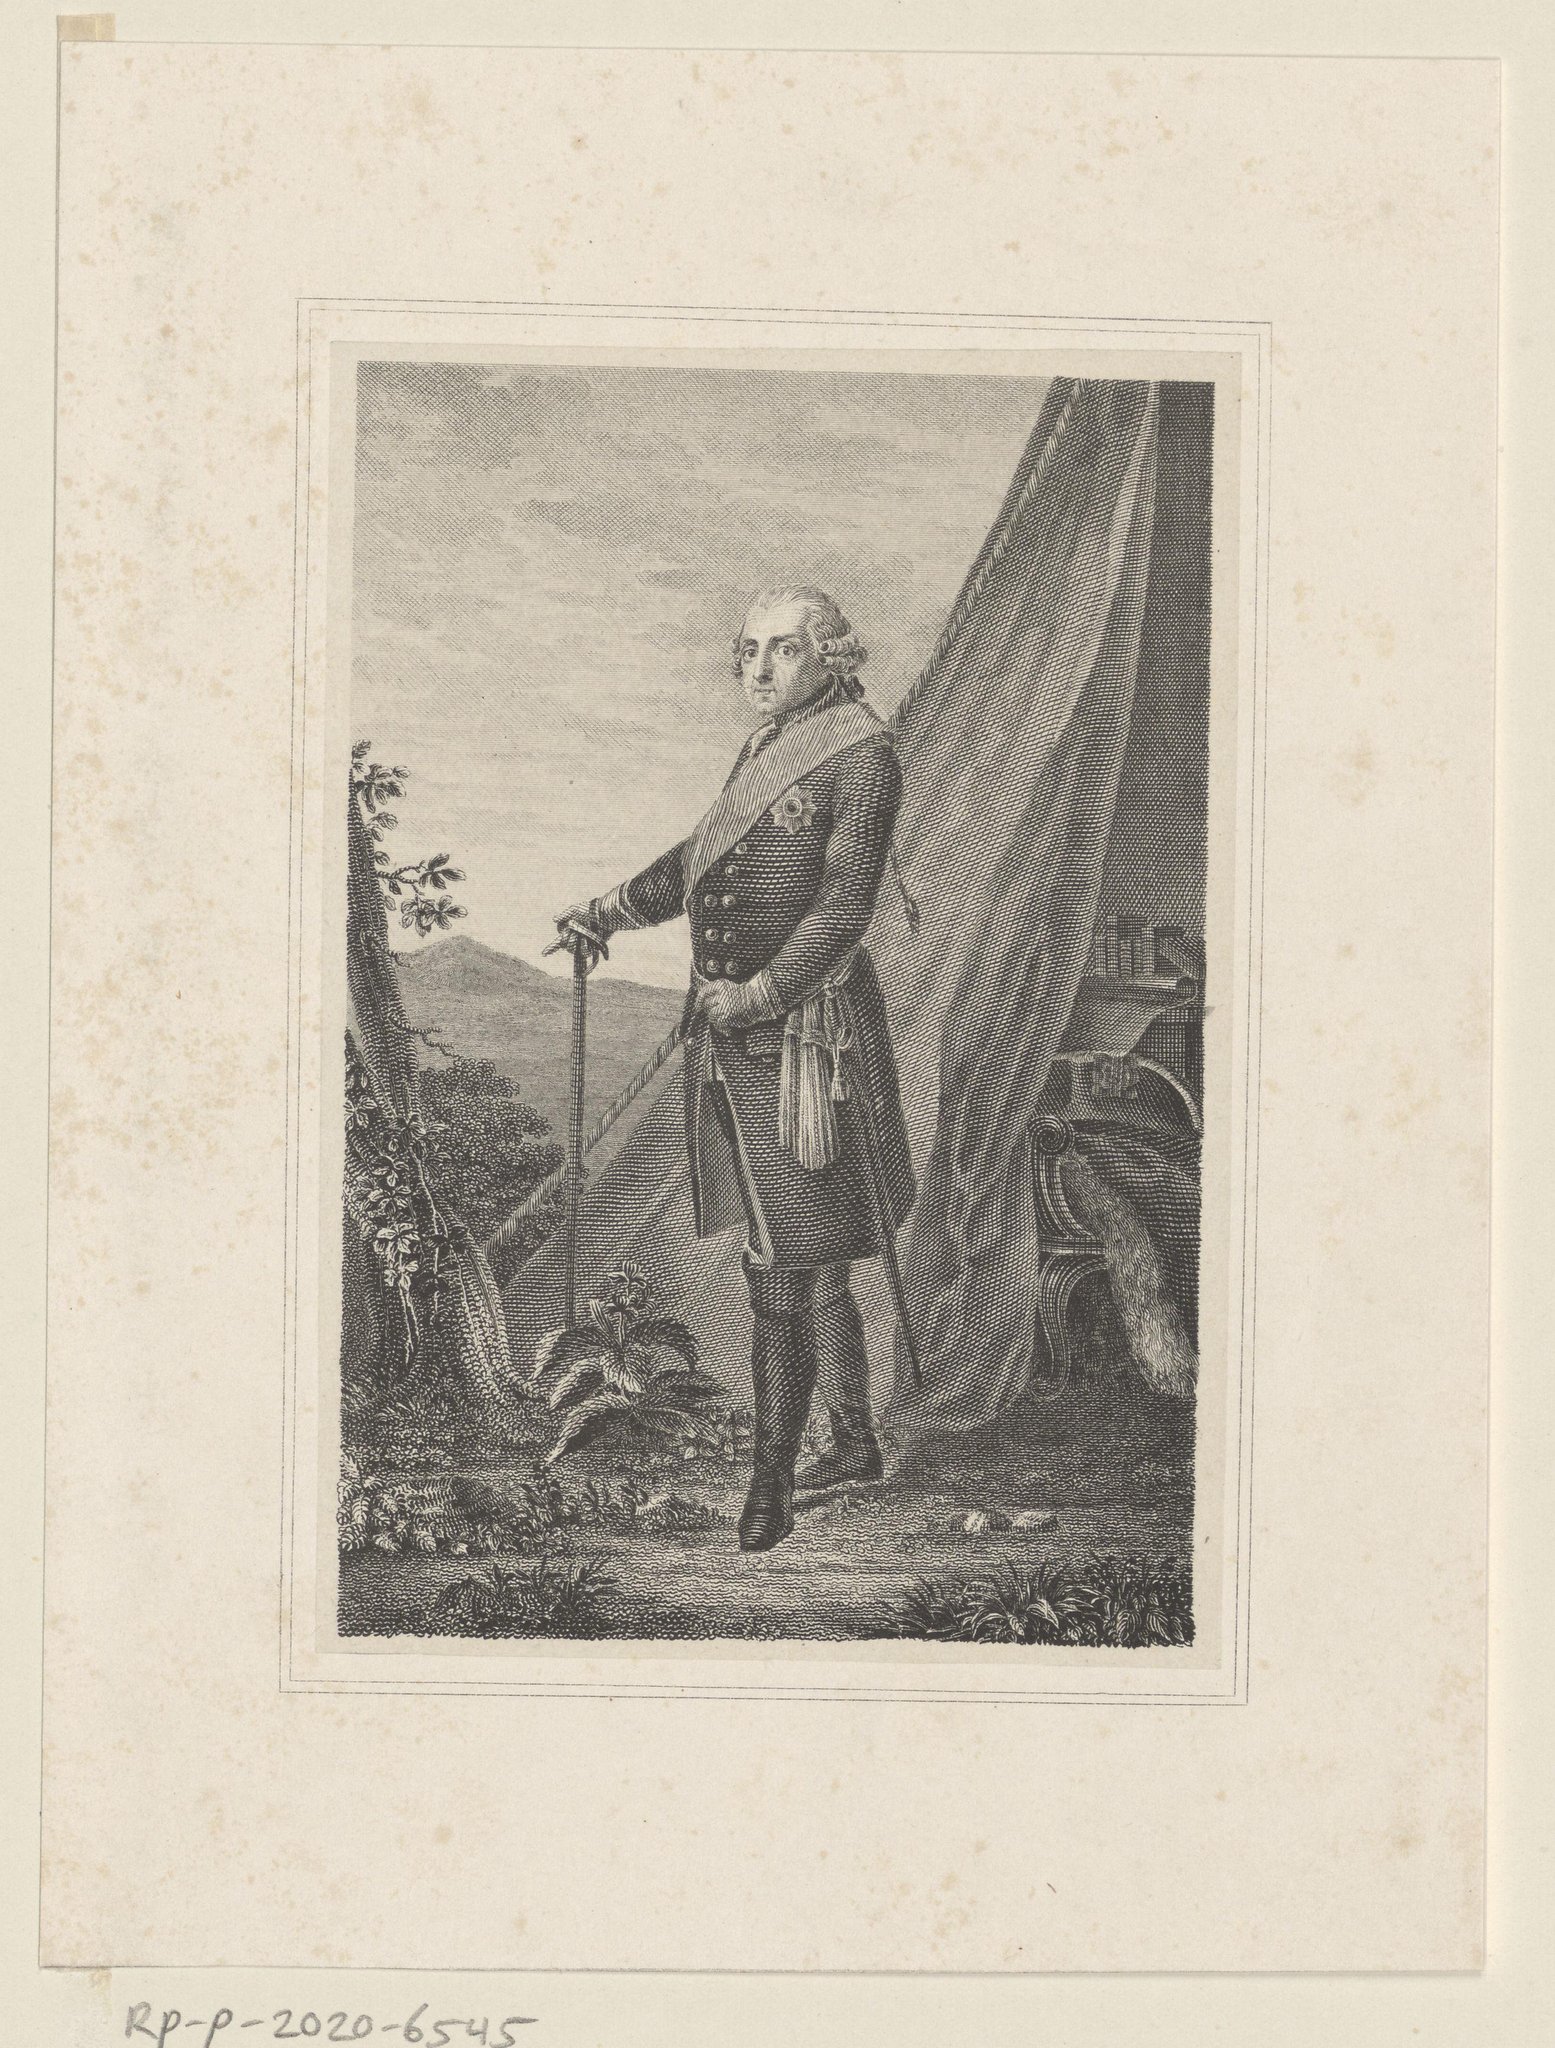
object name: print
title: Portret van Frederik de Grote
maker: Anonymous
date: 1820-1870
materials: paper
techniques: etching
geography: england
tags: berlin, frederick ii (king of prussia), (military) camp with tents, historical persons, king